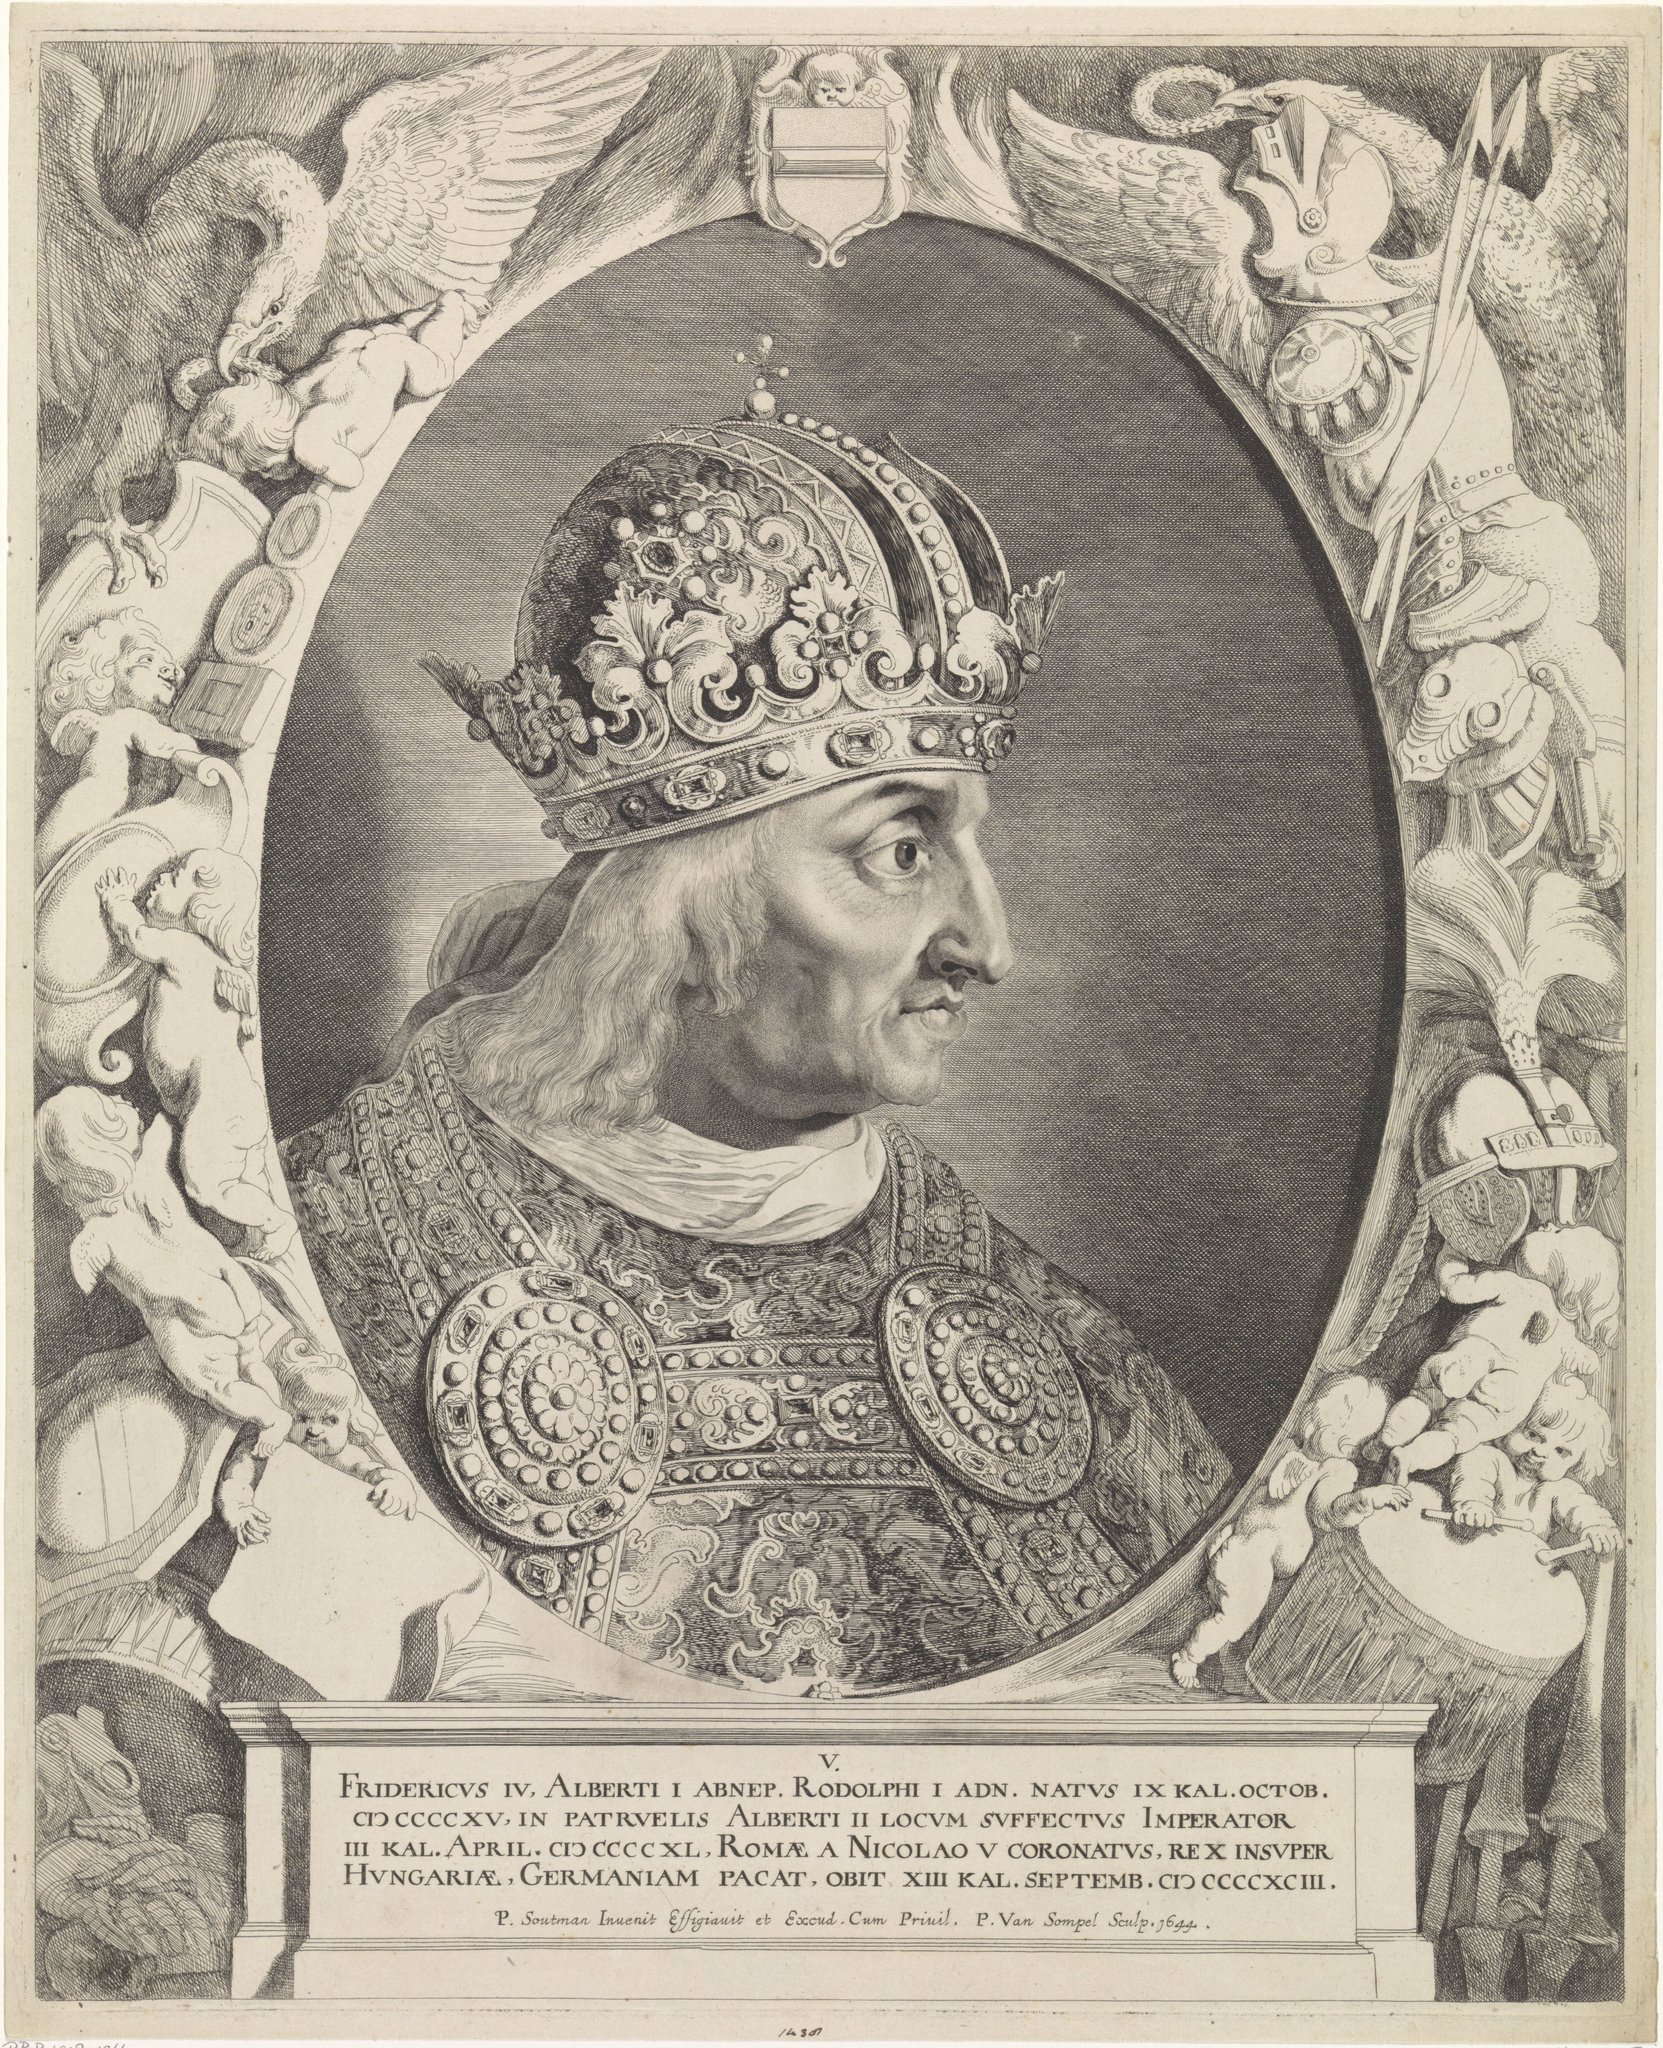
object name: print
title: Portret van Frederik III van Habsburg (Duits keizer), als koning Frederik IV van Duitsland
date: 1644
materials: paper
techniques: engraving, etching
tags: crown (symbol of sovereignty)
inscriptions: collector's mark: Lugt 2228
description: Portret van Frederik III van Habsburg (Duits keizer), als koning Frederik IV van Duitsland, met kroon. Het portret wordt omlijst door een randversiering met putti, wapens en harnasonderdelen. In de beide bovenhoeken een adelaar, in het midden zijn wapenschild. Onder het portret een voetstuk met daarop in het Latijn zijn naam, titels en een korte levensbeschrijving. Genummerd "V".